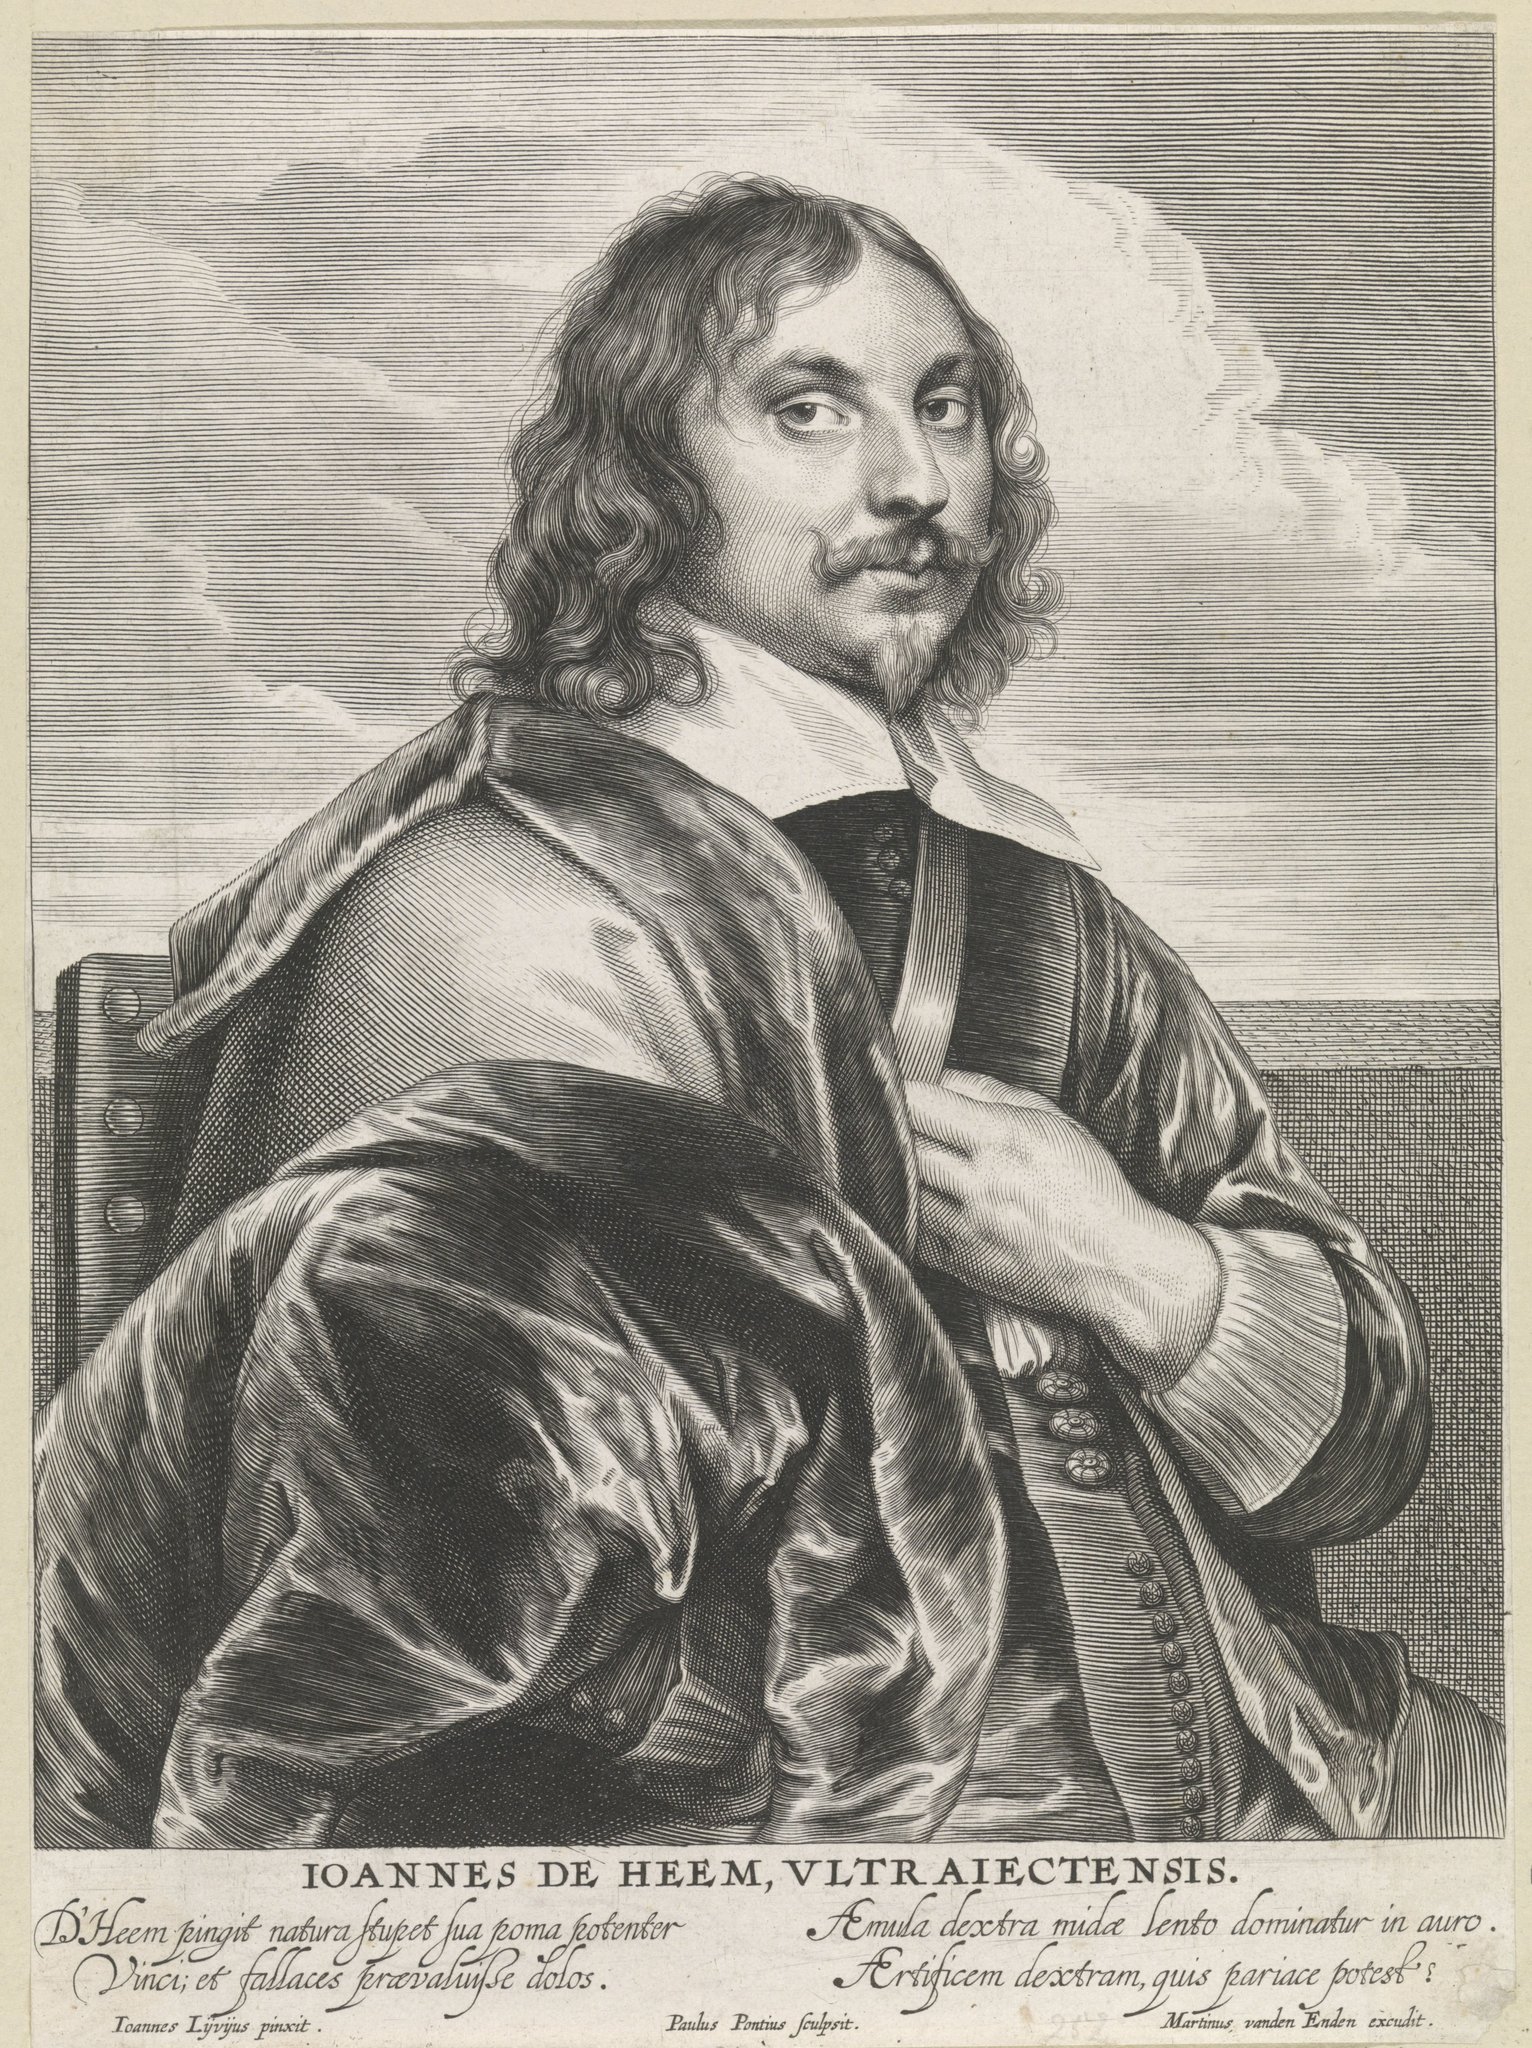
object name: print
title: Portret van de schilder Jan Davidsz. de Heem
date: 1616-1657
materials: paper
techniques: engraving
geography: antwerp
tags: antwerp, painter, jan davidsz. de heem, portrait, self-portrait of painter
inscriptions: collector's mark: Lugt 240